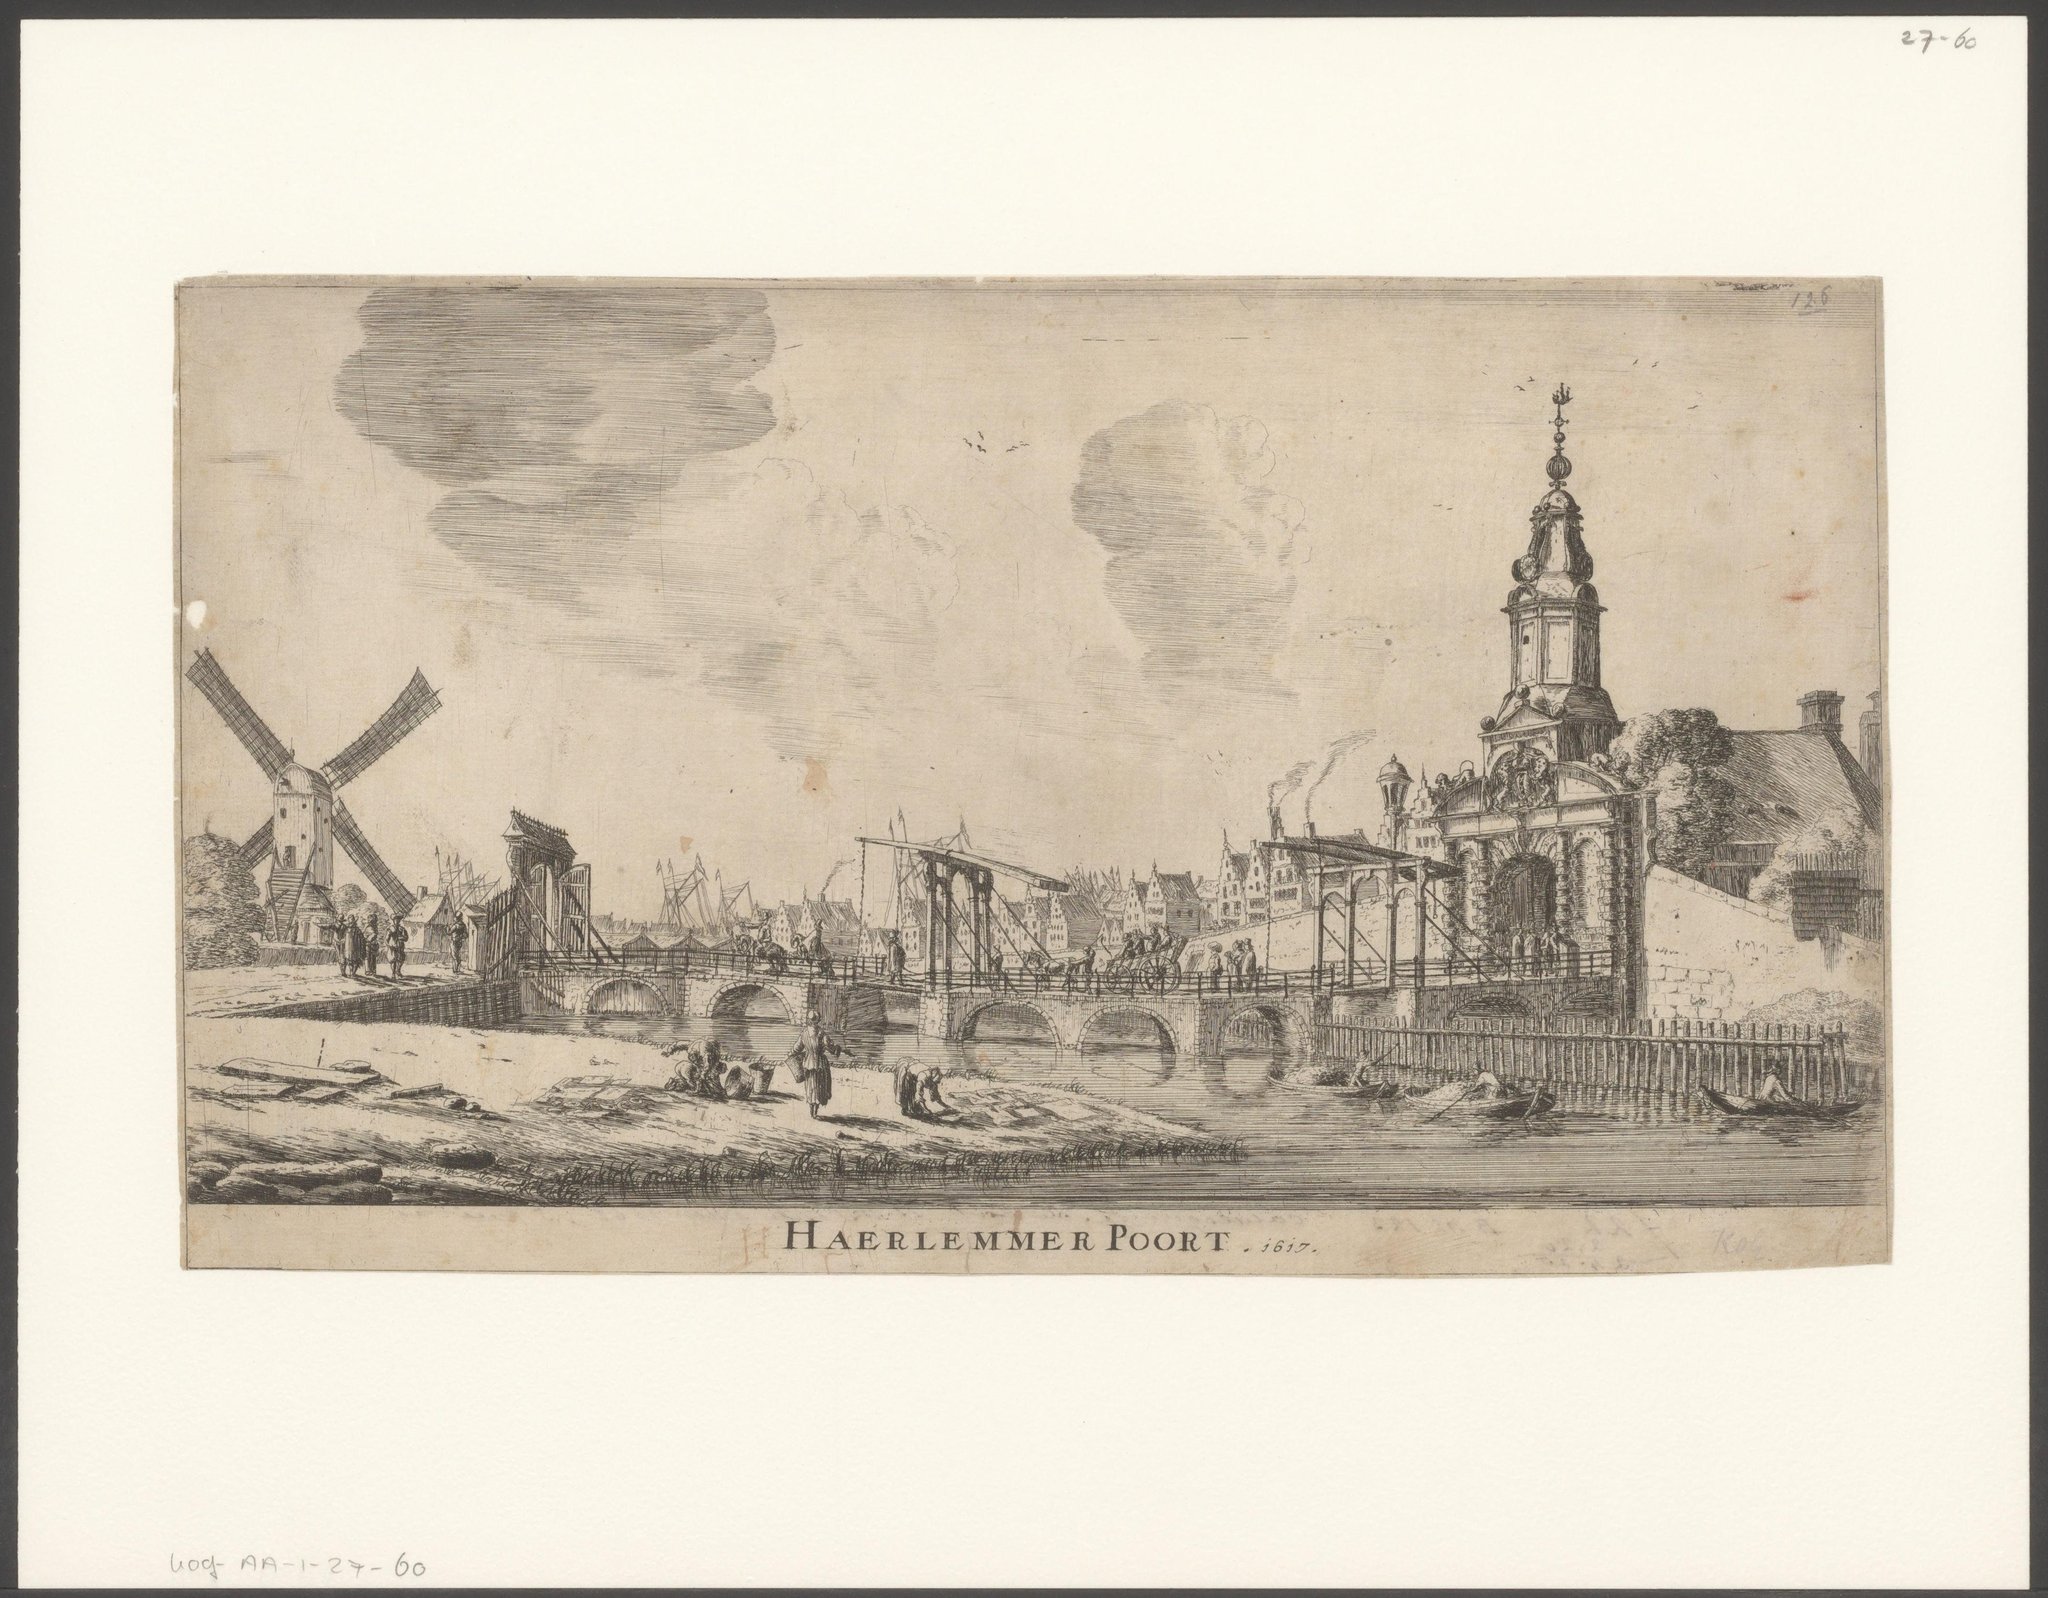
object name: print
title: Gezicht op de Haarlemmerpoort te Amsterdam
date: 1653-1701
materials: paper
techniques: drypoint, engraving, etching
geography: amsterdam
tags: tower, clock tower ~ monumental adornment, windmill, city-gate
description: Onderdeel van een prentserie bestaande uit een titelprent en zeven prenten van Amsterdamse stadspoorten of alleen zeven (of zes) prenten van Amsterdamse stadspoorten. Van deze prentserie zijn drie uitgaven bekend, respectievelijk uitgegeven door Cornelis Danckerts (I), Dancker Danckerts en Justus Danckerts. Van de titelprent zijn drie staten bekend: één staat voor de letter waarop het droge naaldwerk nog goed zichtbaar is, één staat waarop Dancker Danckerts als uitgever vermeld staat; en één staat waarop Justus Danckerts als uitgever vermeld staat. De serie uitgegeven door Cornelis (I) Danckerts had mogelijk geen titelprent. Van elk van de overige prenten zijn redelijk wat exemplaren overgeleverd maar is telkens slechts één staat bekend. Op vier van deze prenten staat Cornelis Danckerts (I) vermeld als uitgever. Op twee prenten staat geen uitgever vermeld en op één prent staat Dancker Danckerts vermeld als uitgever. Mogelijk hebben zowel Dancker als Justus voor hun uitgave hun naam op de titelprent vermeld zonder de overige prenten bij te werken. Dat zou betekenen dat de prenten waarop Cornelis (I) staat vermeld als uitgever, ook later door zijn zoons Dancker en Justus kunnen zijn uitgegeven. En dat de prent waarop Danker vermeld staat als uitgever ook door Justus kan zijn uitgeven. Dat op de prent van de Derde Regulierspoort (RP-P-AO-27-15-2 en RP-P-1882-A-6003) wel - in een net andere stijl - de naam van Dancker Danckerts staat, zou verklaard kunnen worden doordat deze prent iets later, na het overlijden van Cornelis (I) in 1656, aan de serie is toegevoegd. De serie bevat namelijk ook een prent van de Tweede Regulierspoort (RP-P-AO-27-4-2 en RP-P-OB-20.579). Deze houten poort werd in 1654 afgebroken en vervangen door de stenen Derde Regulierspoort die in 1655 voltooid zou zijn.